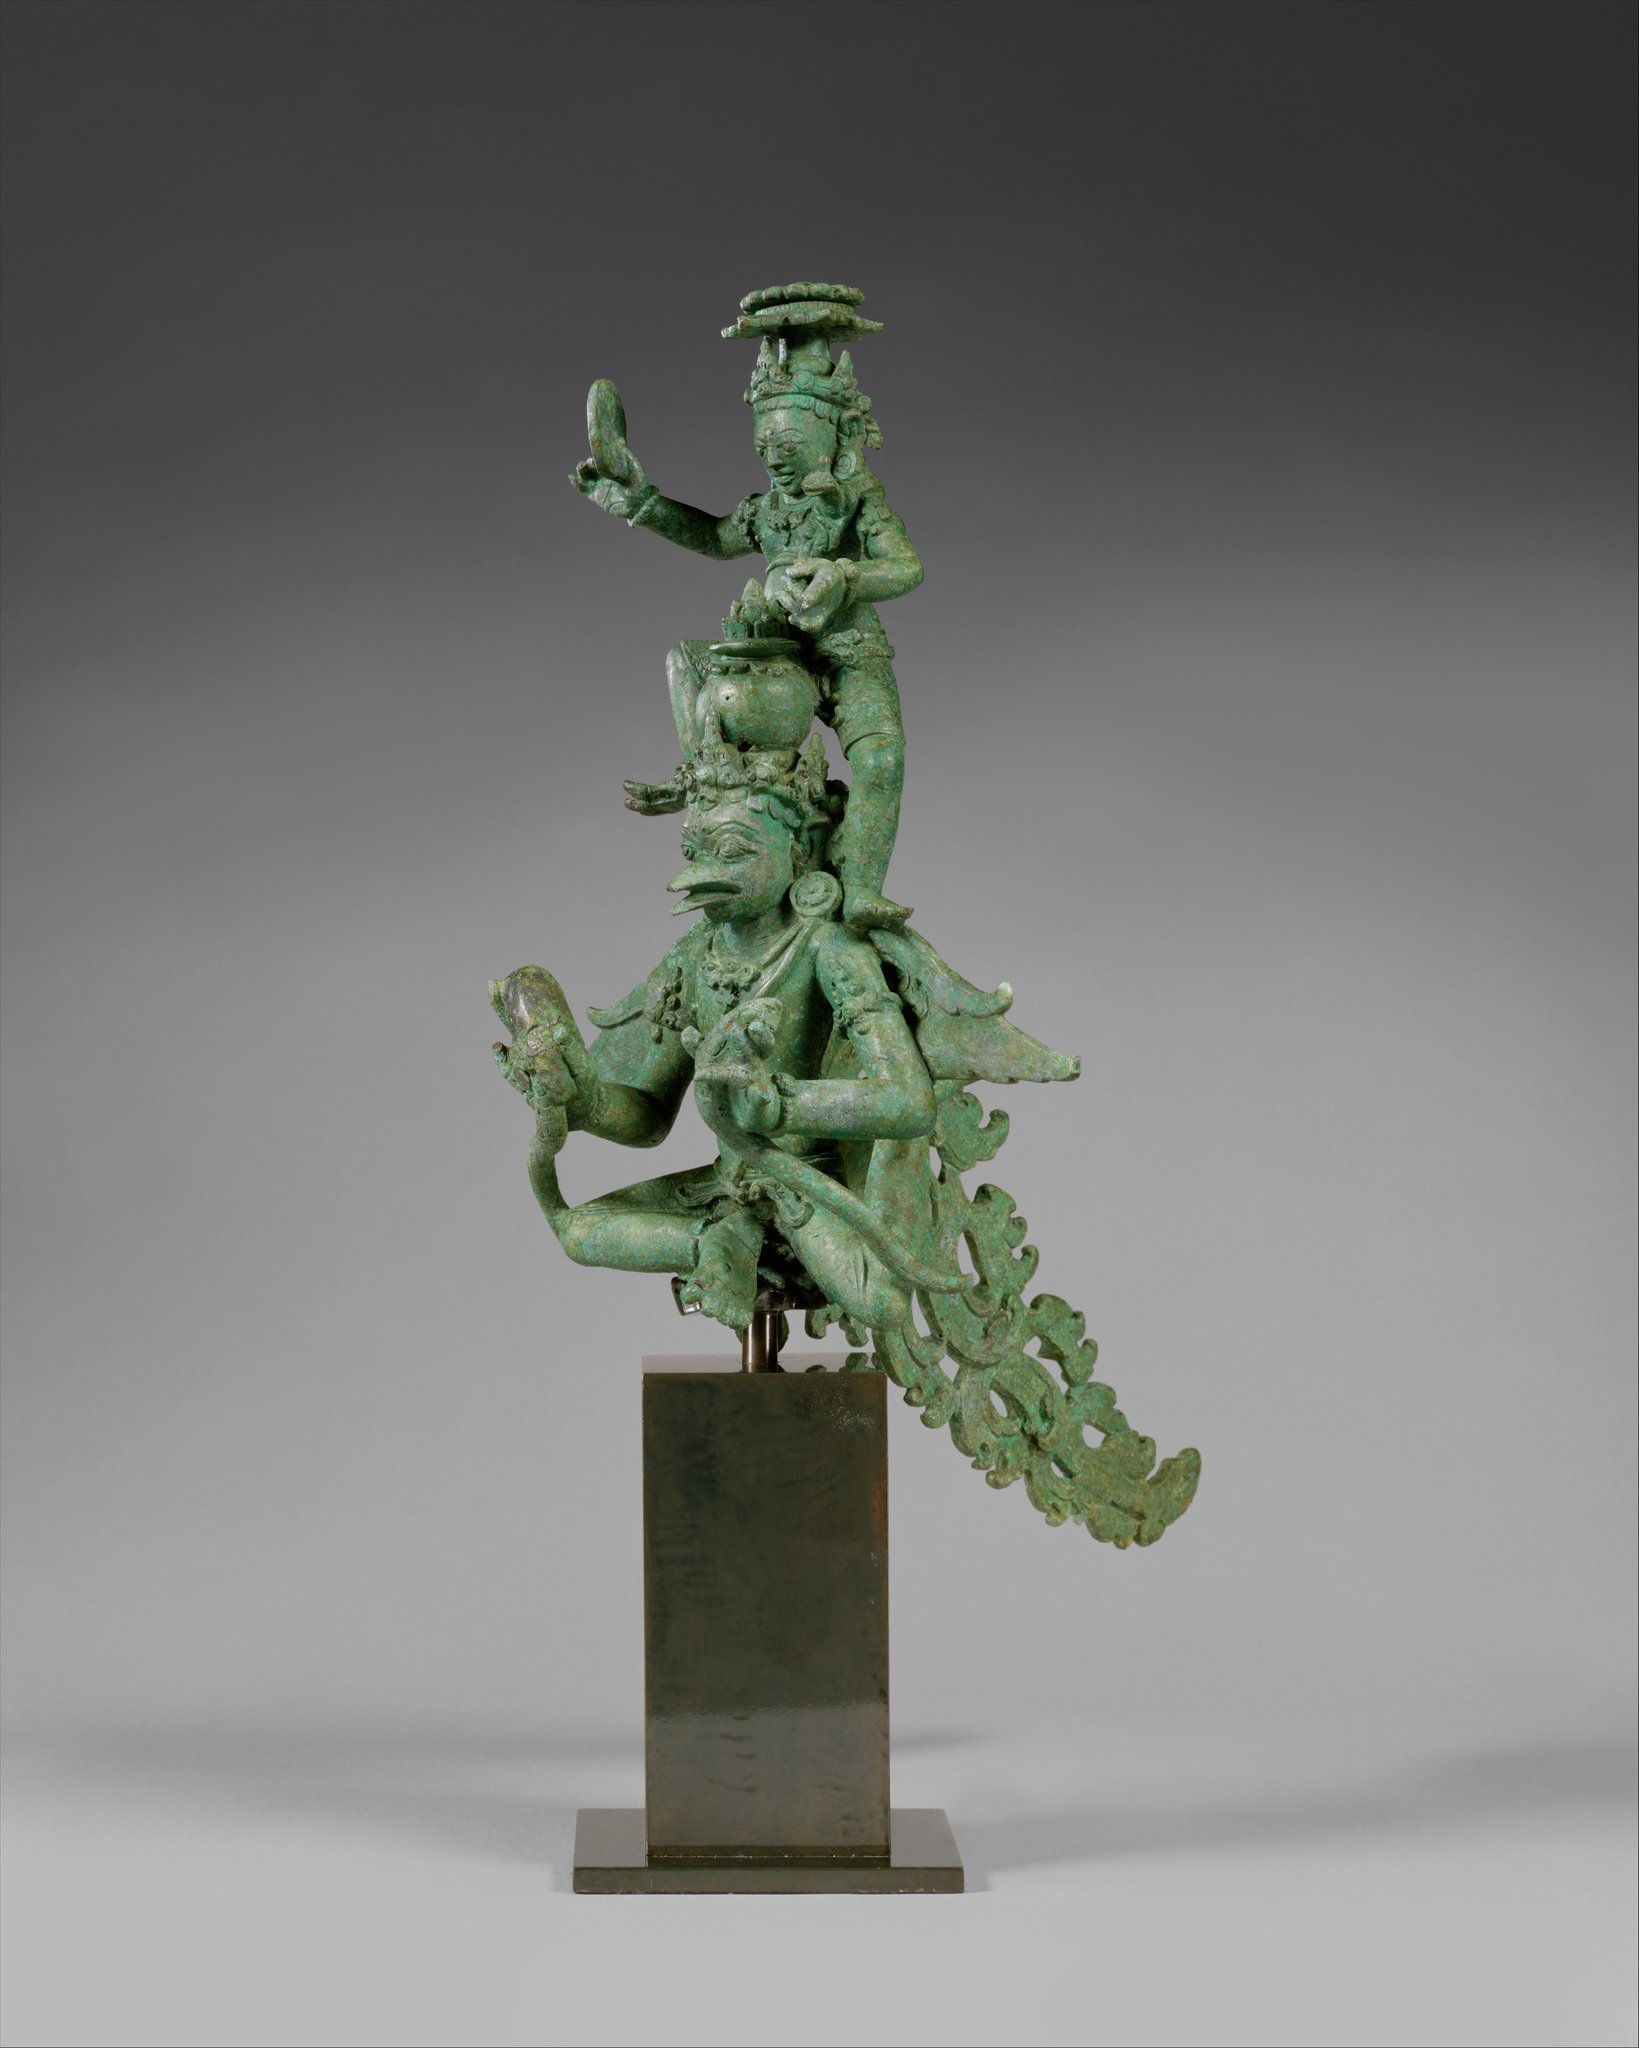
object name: figure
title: Krishna on Garuda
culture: indonesian, javanese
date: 851-900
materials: bronze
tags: krishna